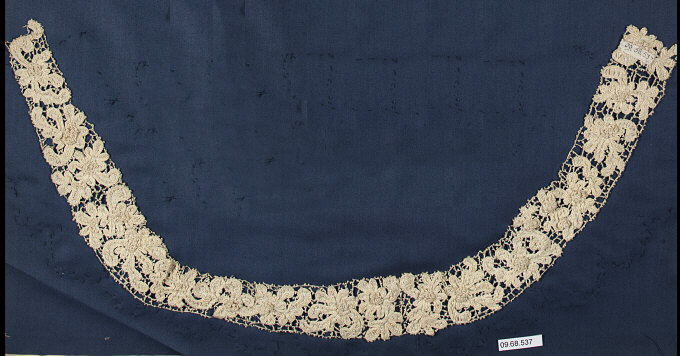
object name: border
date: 1801-1833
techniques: lace